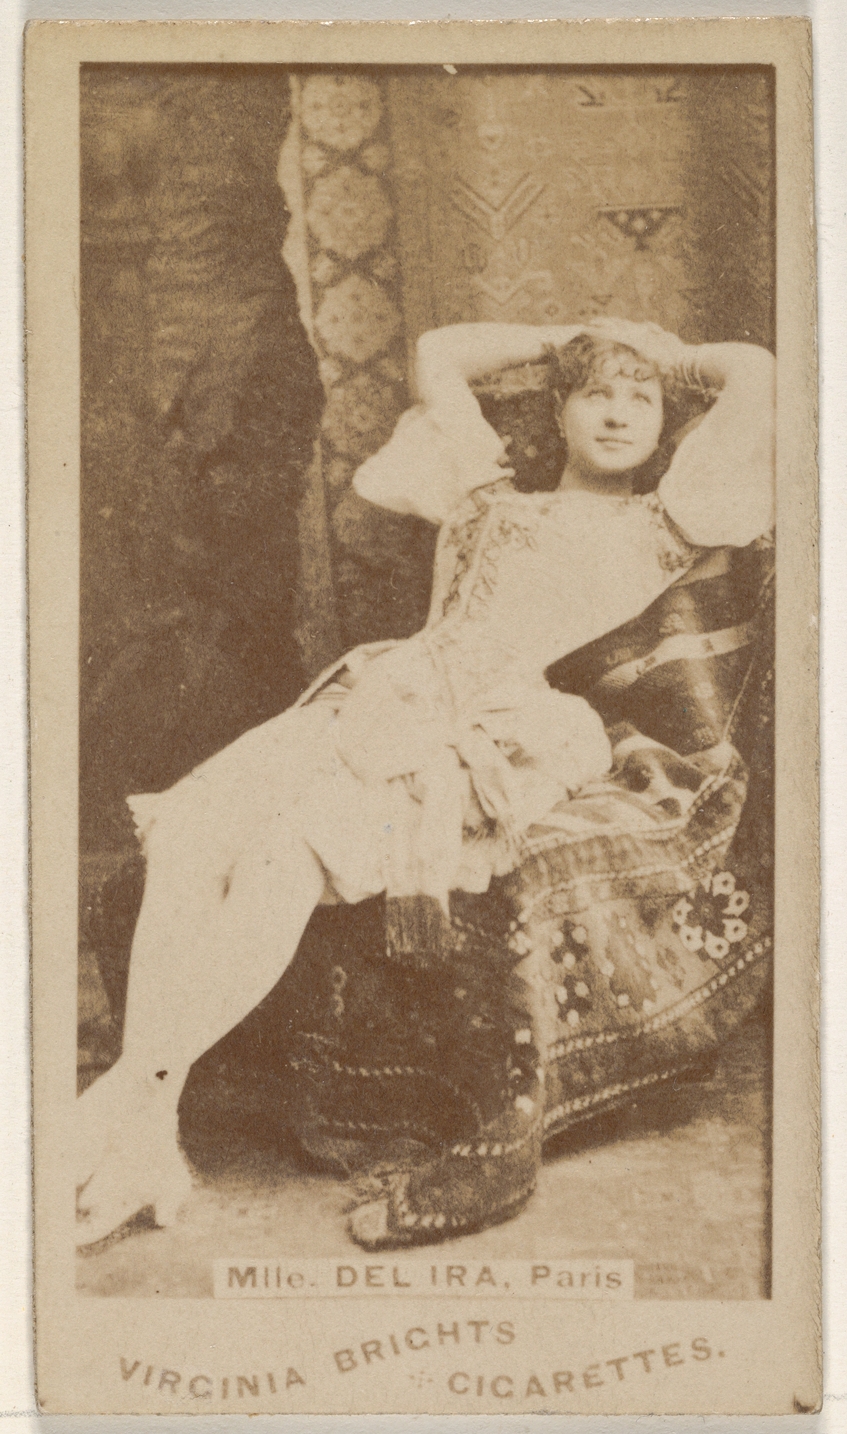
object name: photograph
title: Mlle. Del Ira, Paris, from the Actors and Actresses series (N45, Type 1) for Virginia Brights Cigarettes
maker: allen & ginter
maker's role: publisher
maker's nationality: american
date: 1888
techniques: albumen silver print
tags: girls,portraits,actresses